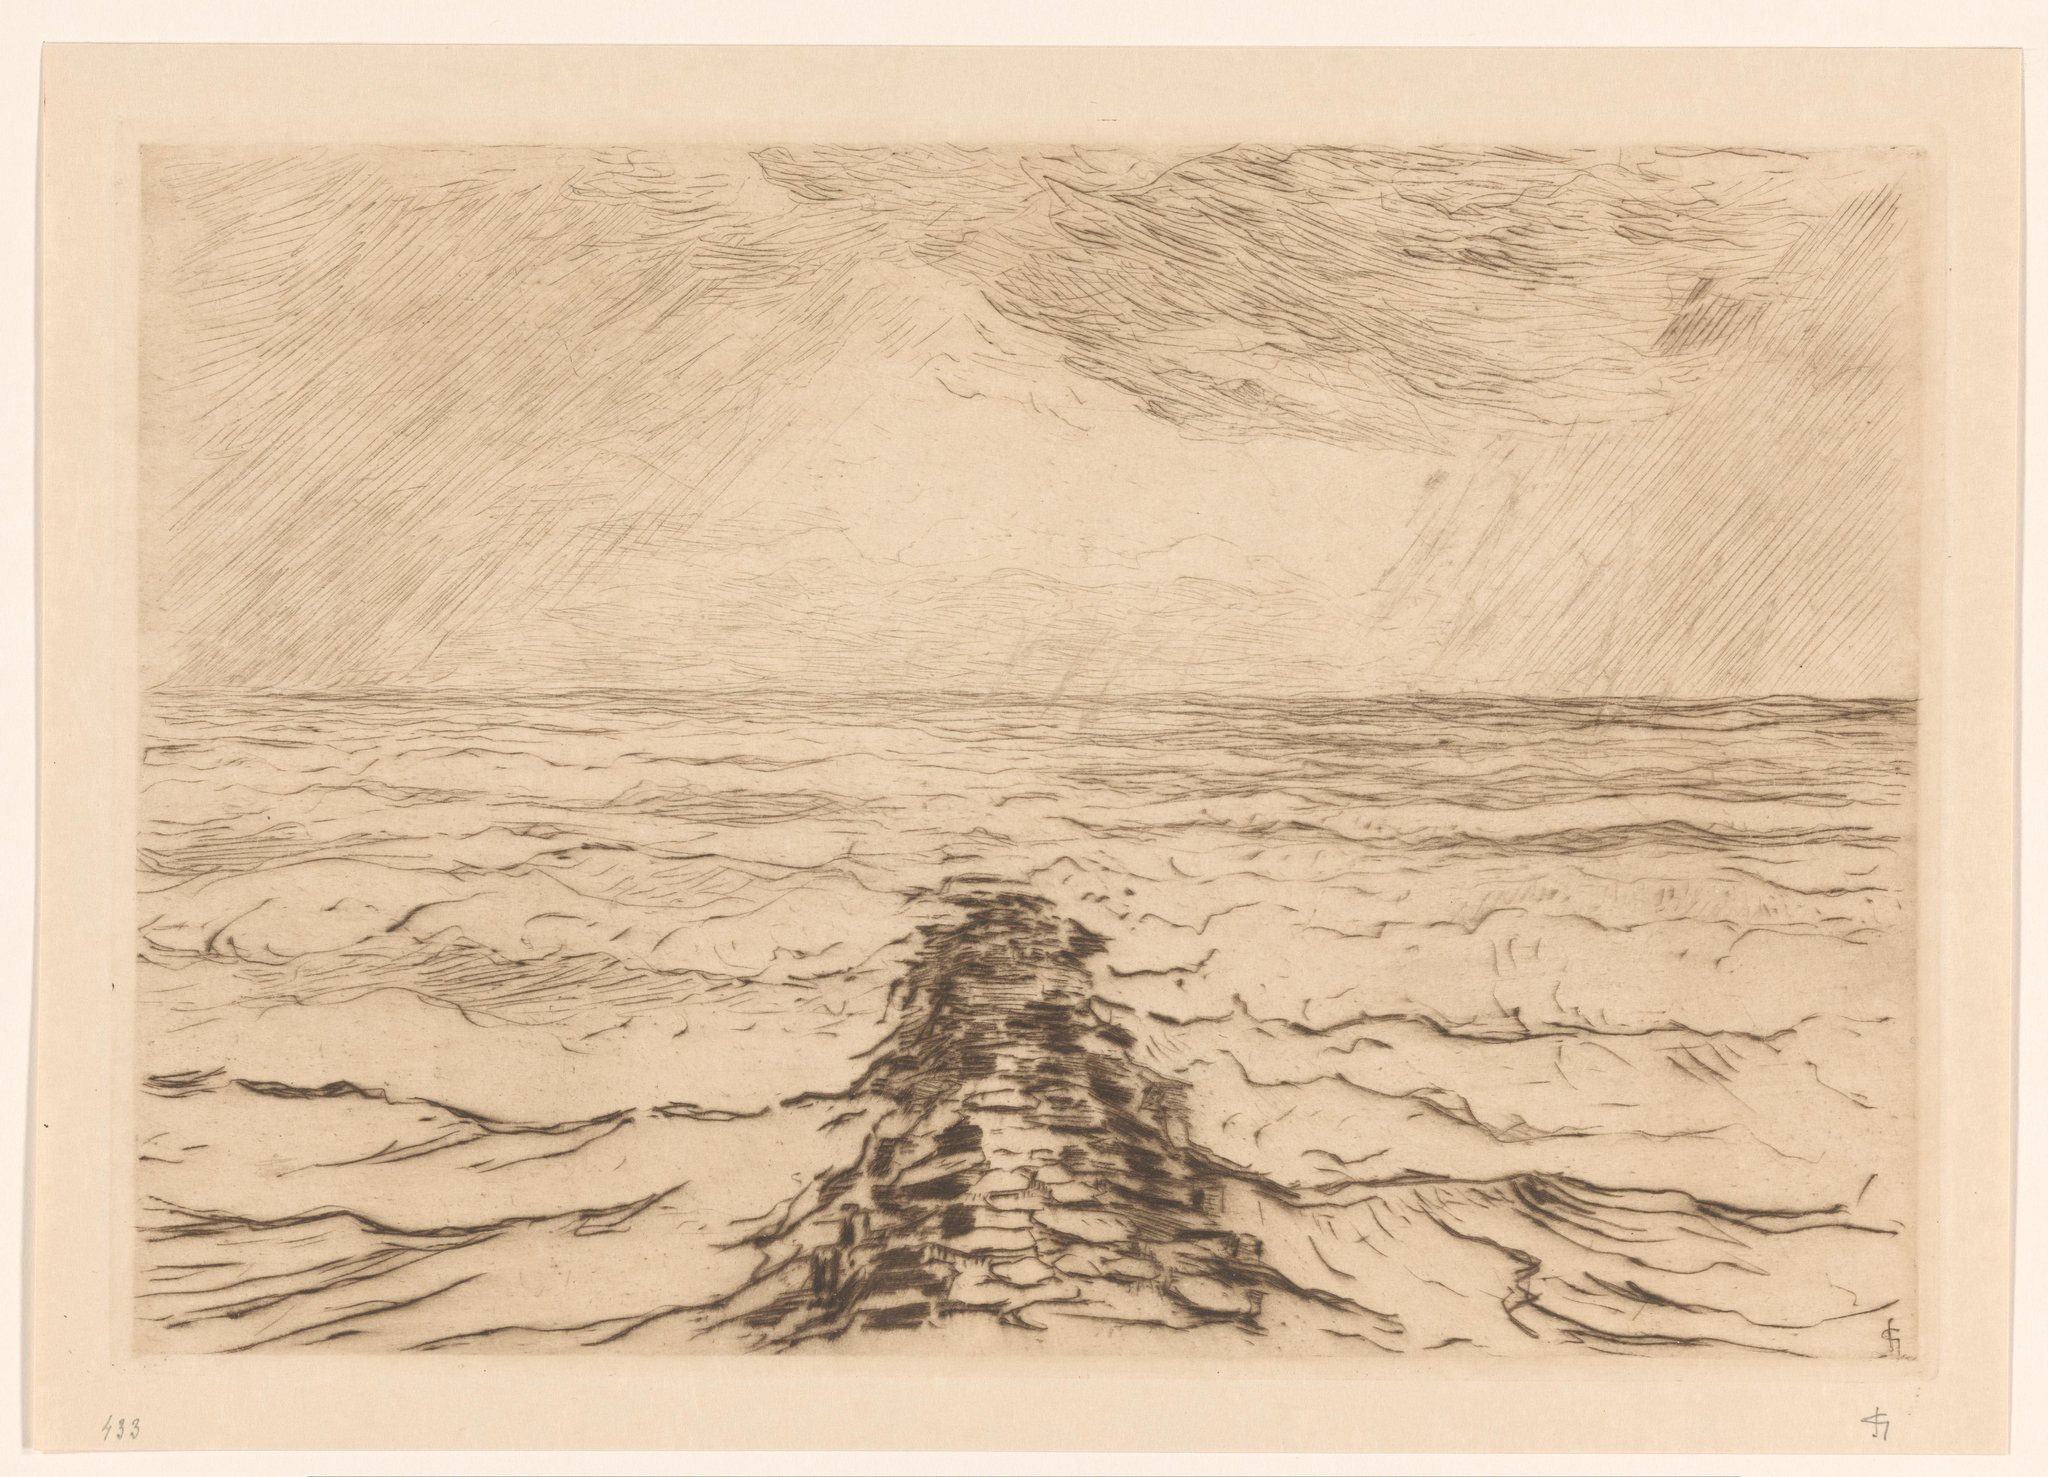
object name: print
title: Zeegezicht met golfbreker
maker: carel nicolaas storm van s-gravesande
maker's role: draughtsman, print maker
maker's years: 1841-1924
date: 1851-1902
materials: paper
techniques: drypoint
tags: sea (seascape), coastal protection work, breakwater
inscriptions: collector's mark: Lugt 2228, number: ‘433’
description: Mogelijk vermeld in: Storm van 's-Gravesande, Charles. Catalogue des eaux-fortes et lithographies. New York: s.n., 1903, of in een onbekende latere uitgave van het manuscript. Vermoedelijk vermeld als catalogusnummer 433.